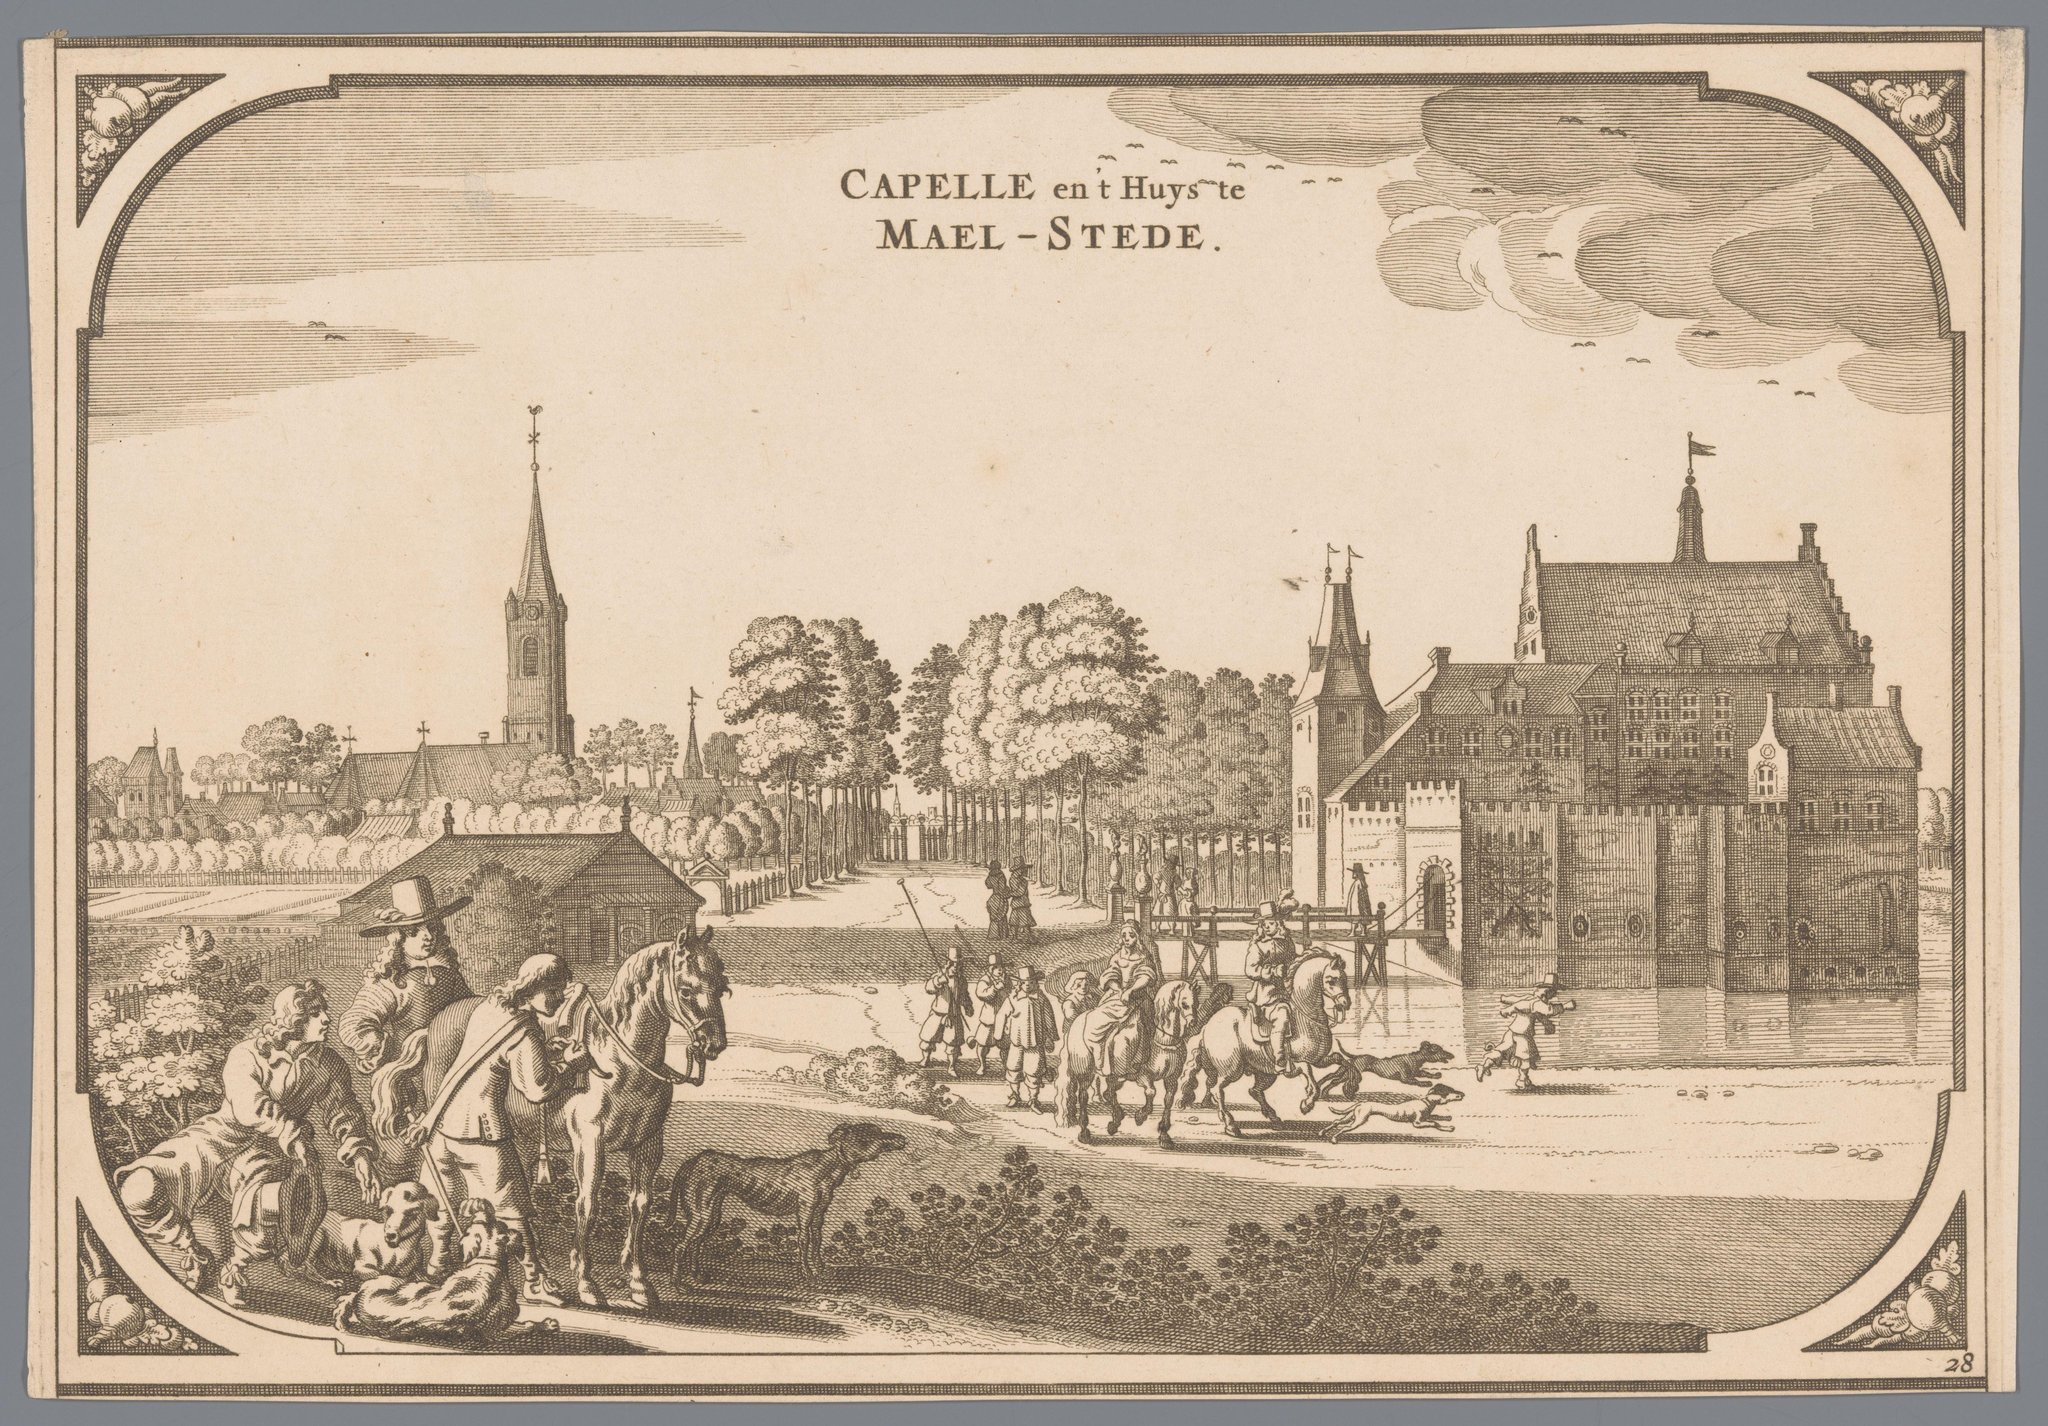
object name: print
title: Capelle en 't Huys te Mael-Stede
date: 1662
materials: paper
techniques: engraving, etching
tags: prospect of village, silhouette of village, castle, church (exterior)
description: Prent uit: Speculum Zelandiae dat is een beschryvinge ofte afbeelding der steden, ambachts-heerlijckheden, dorpen, castelen, ridderlijcke hofsteden, huysen en gebouwen gelegen inde eylanden en de graeflijckheyt van Zeelandt, bij een vergadert' door Nicolaus Visscher. S.l.: Nicolaes Visscher, [1662]. Verschillende staten van prenten zijn gebruikt in andere uitgaven van 'Speculum Zelandiae' en in andere publicaties uitgegeven door Zacharias Roman en Nicolaes Visscher (I). Verwarring rondom de datering kan ontstaan door het feit dat de prenten uit 'Speculum Zelandiae' ook voorkomen in eerder uitgegeven publicaties, waar ze later in zijn ingebonden. Zo komen prenten uitgegeven door Roman/Visscher voor in sommige exemplaren van: Boxhorn, Marcus Zuerius van. Chroniick van Zeelandt (…). 2 dln. Middelburg: Zacharias Roman, 1644. De door weduwe (Joachim) Ottens en Zoonen uitgegeven prenten zijn later ingebonden in sommige exemplaren van: Smallegange, Mattheus. Nieuwe Cronyk van Zeeland (…). Middelburg en Amsterdam: Johannes Meertens en Abraham van Someren, 1696.